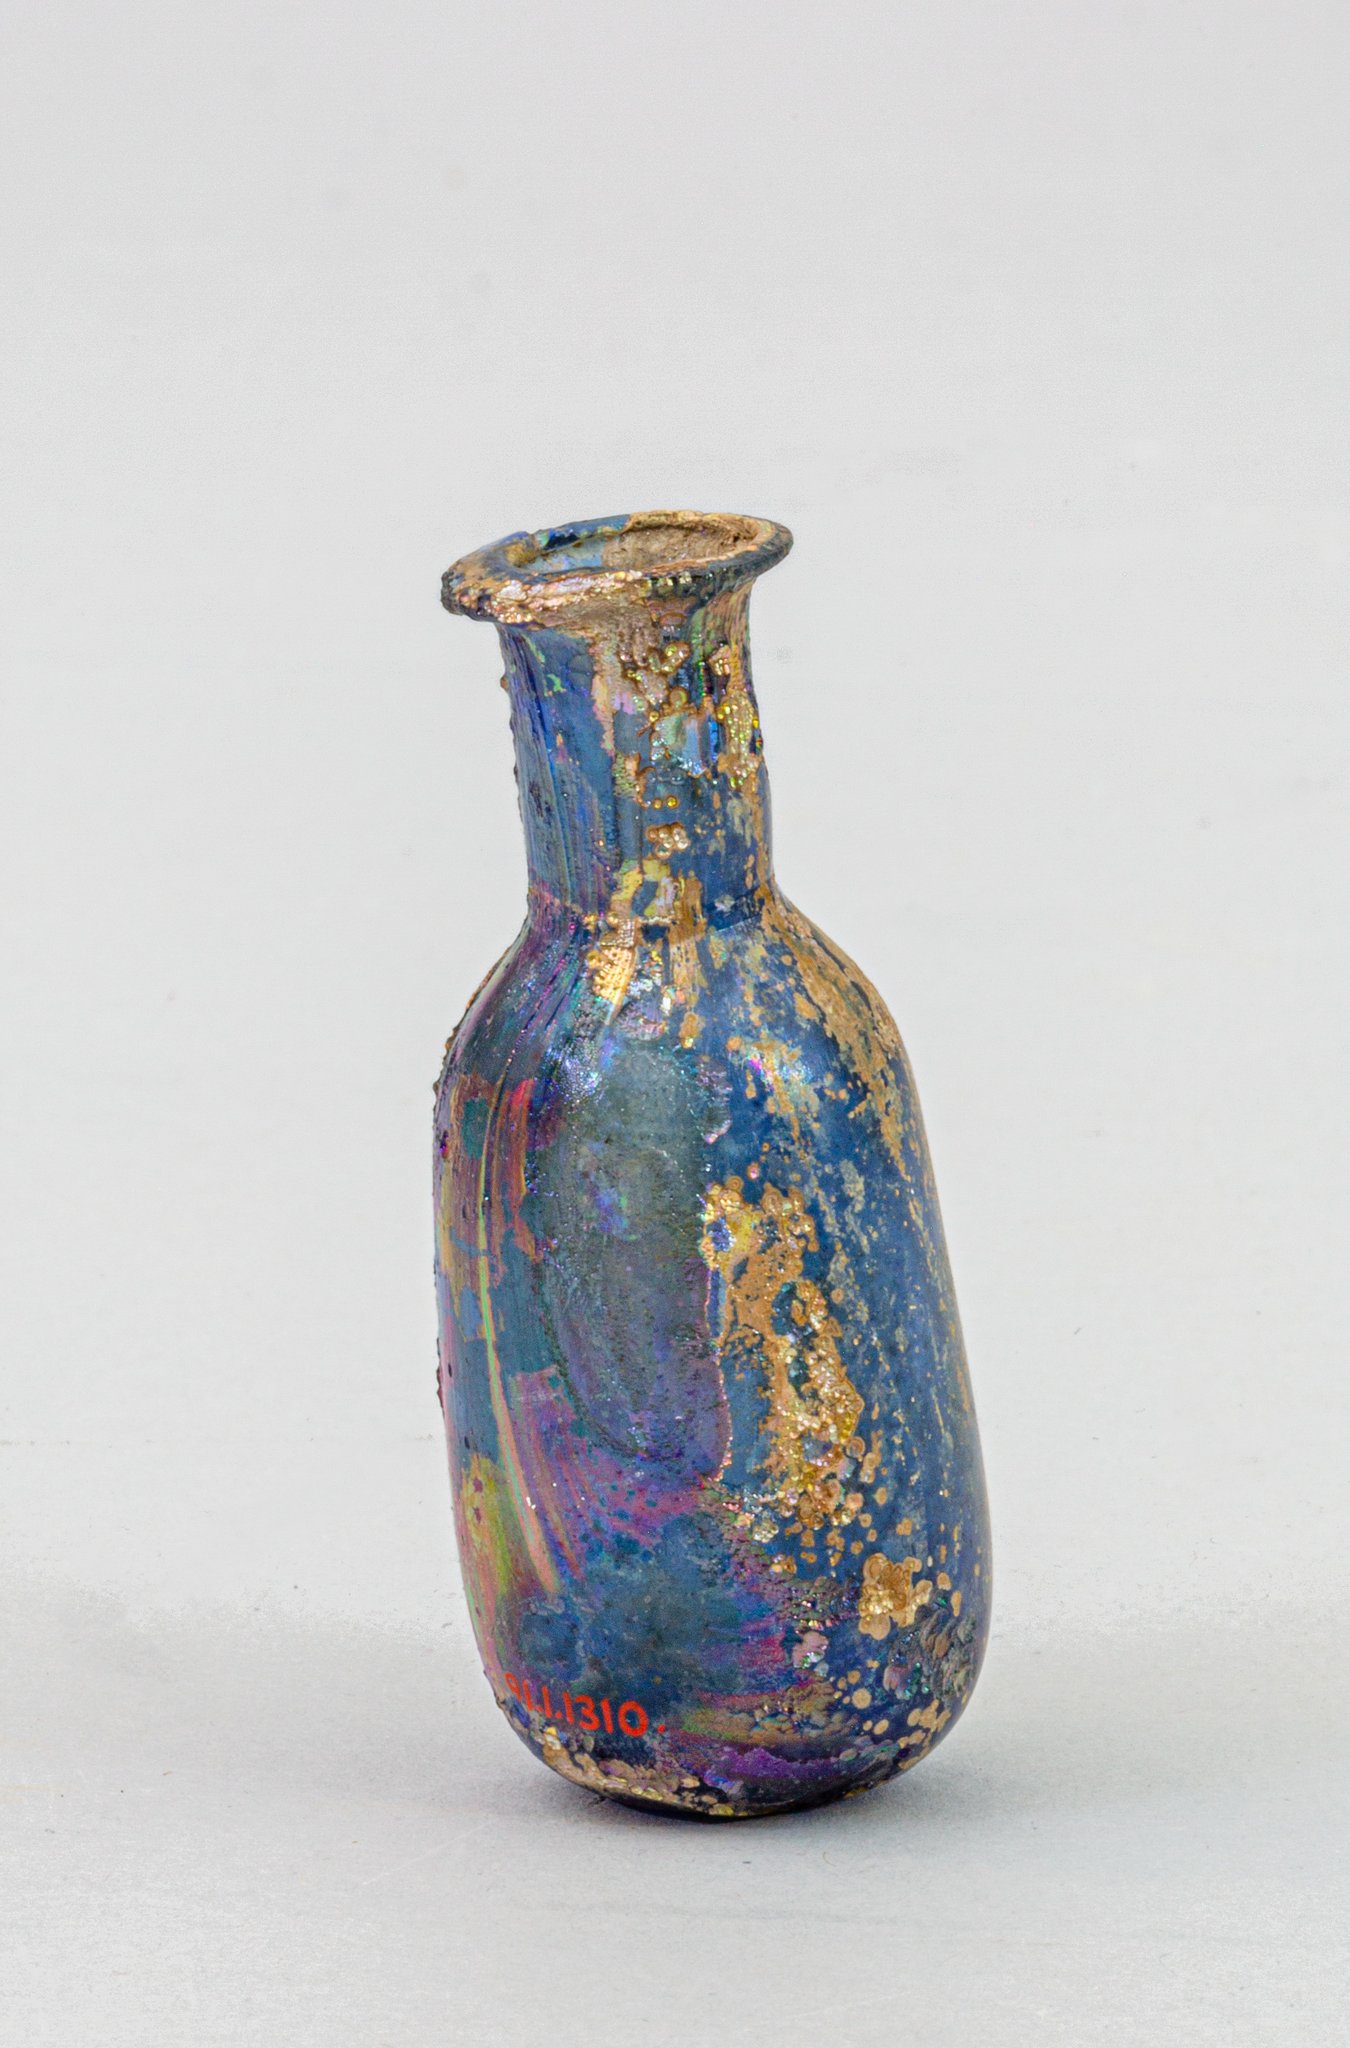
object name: bottle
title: Glass perfume bottle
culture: roman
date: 1-300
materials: glass